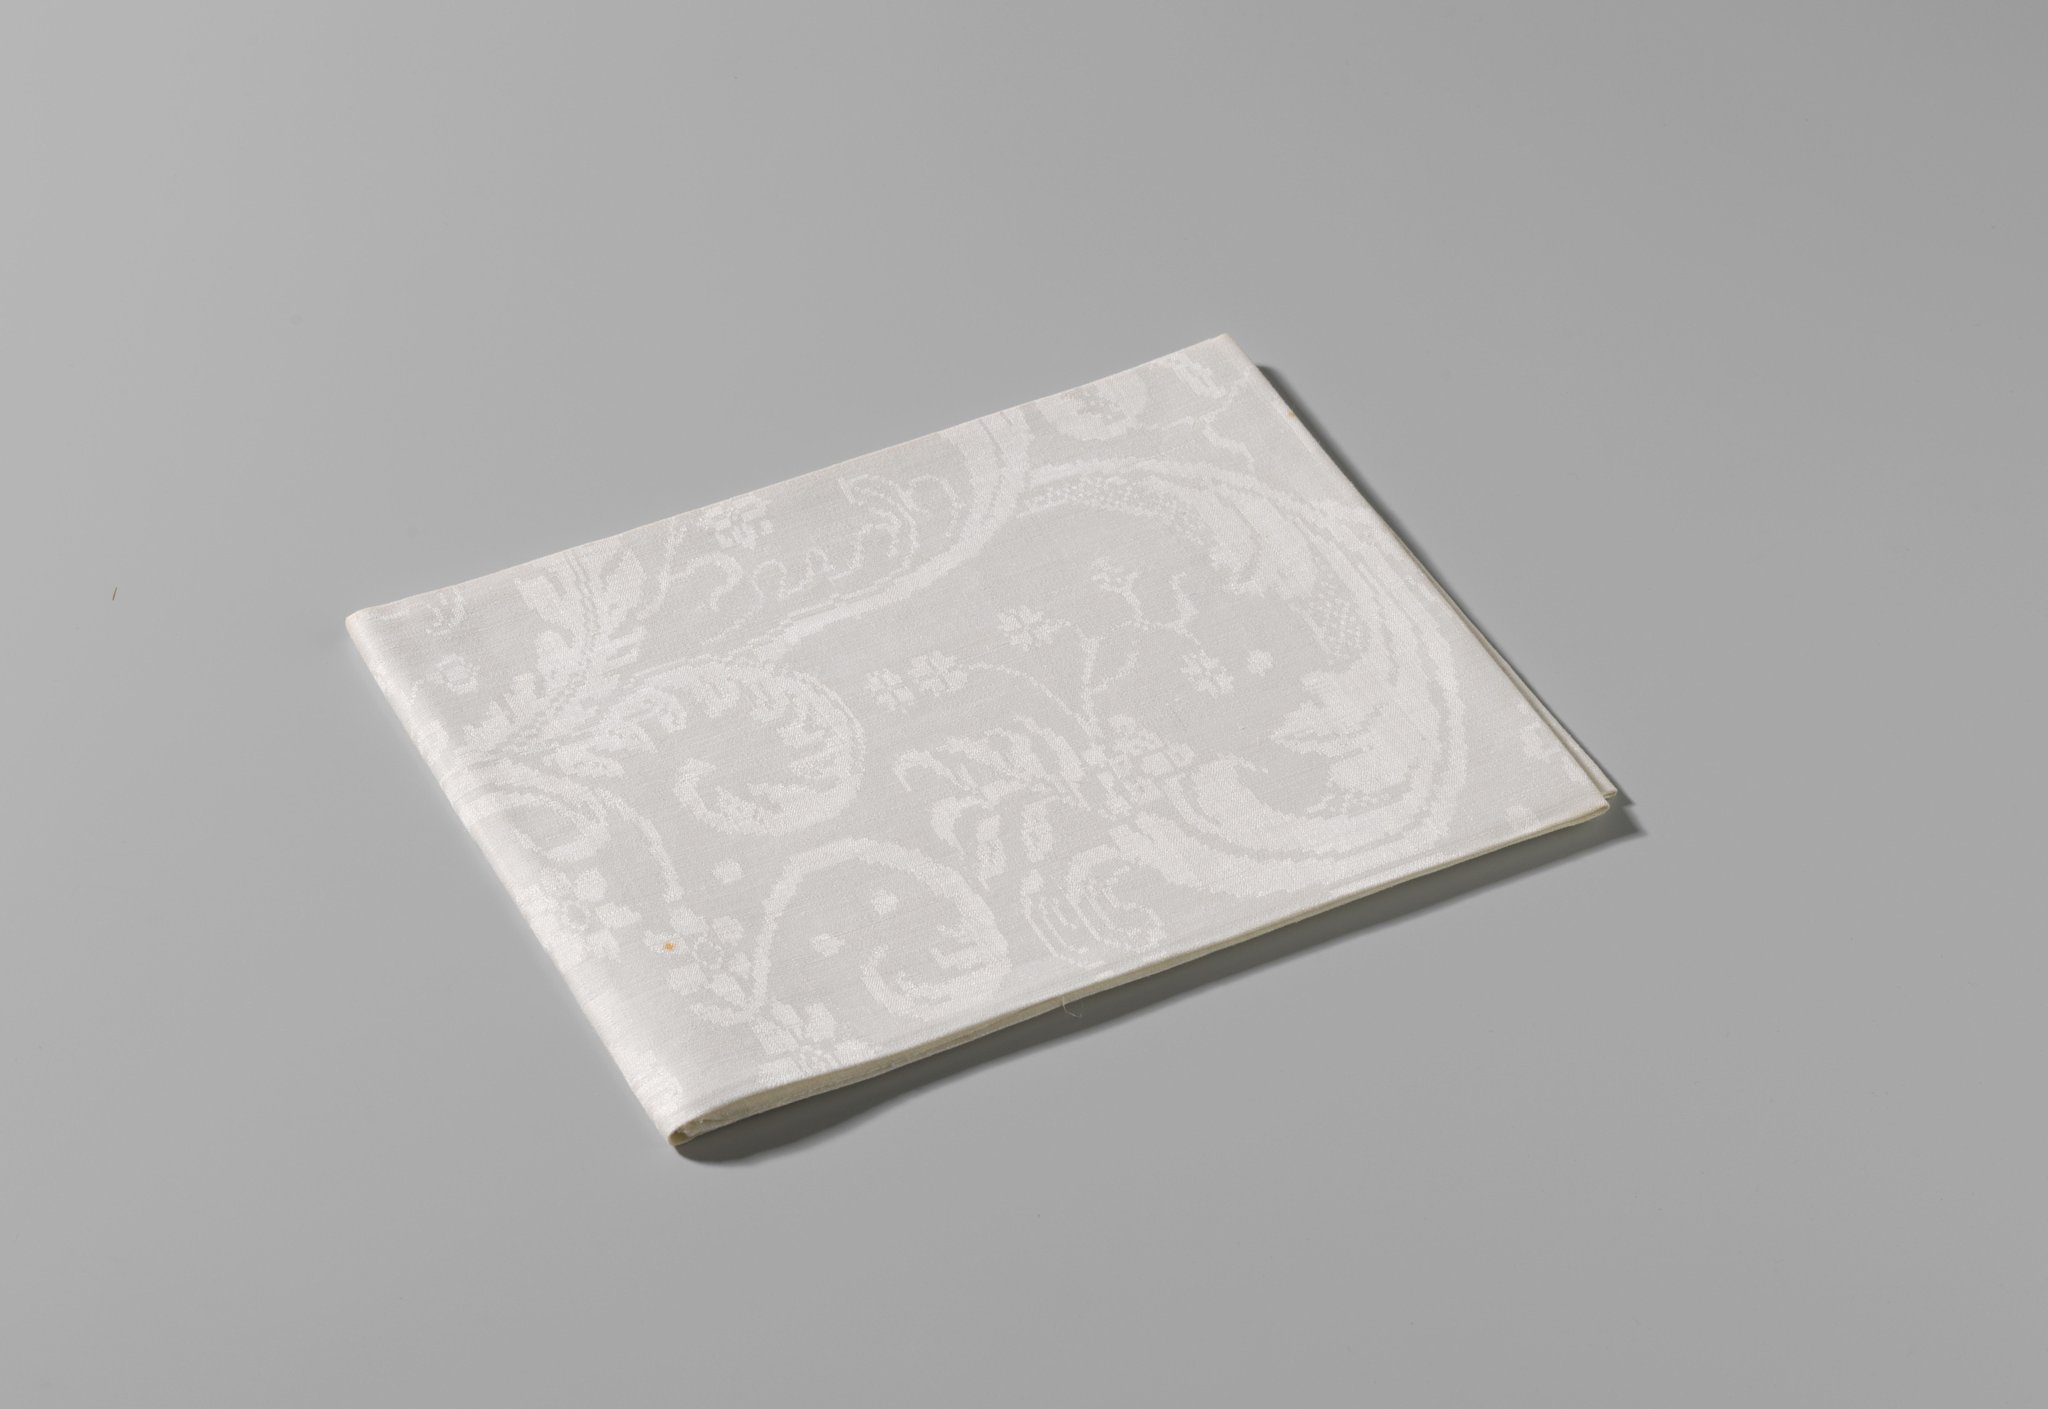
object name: napkin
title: Servet met een bloempatroon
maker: Anonymous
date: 1690-1700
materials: linen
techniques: damask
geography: southern netherlands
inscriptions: mark: ‘26’, mark: ‘DAVA’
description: Servet van linnendamast met voluten en bloemen. Randen met vazen met bloemen.